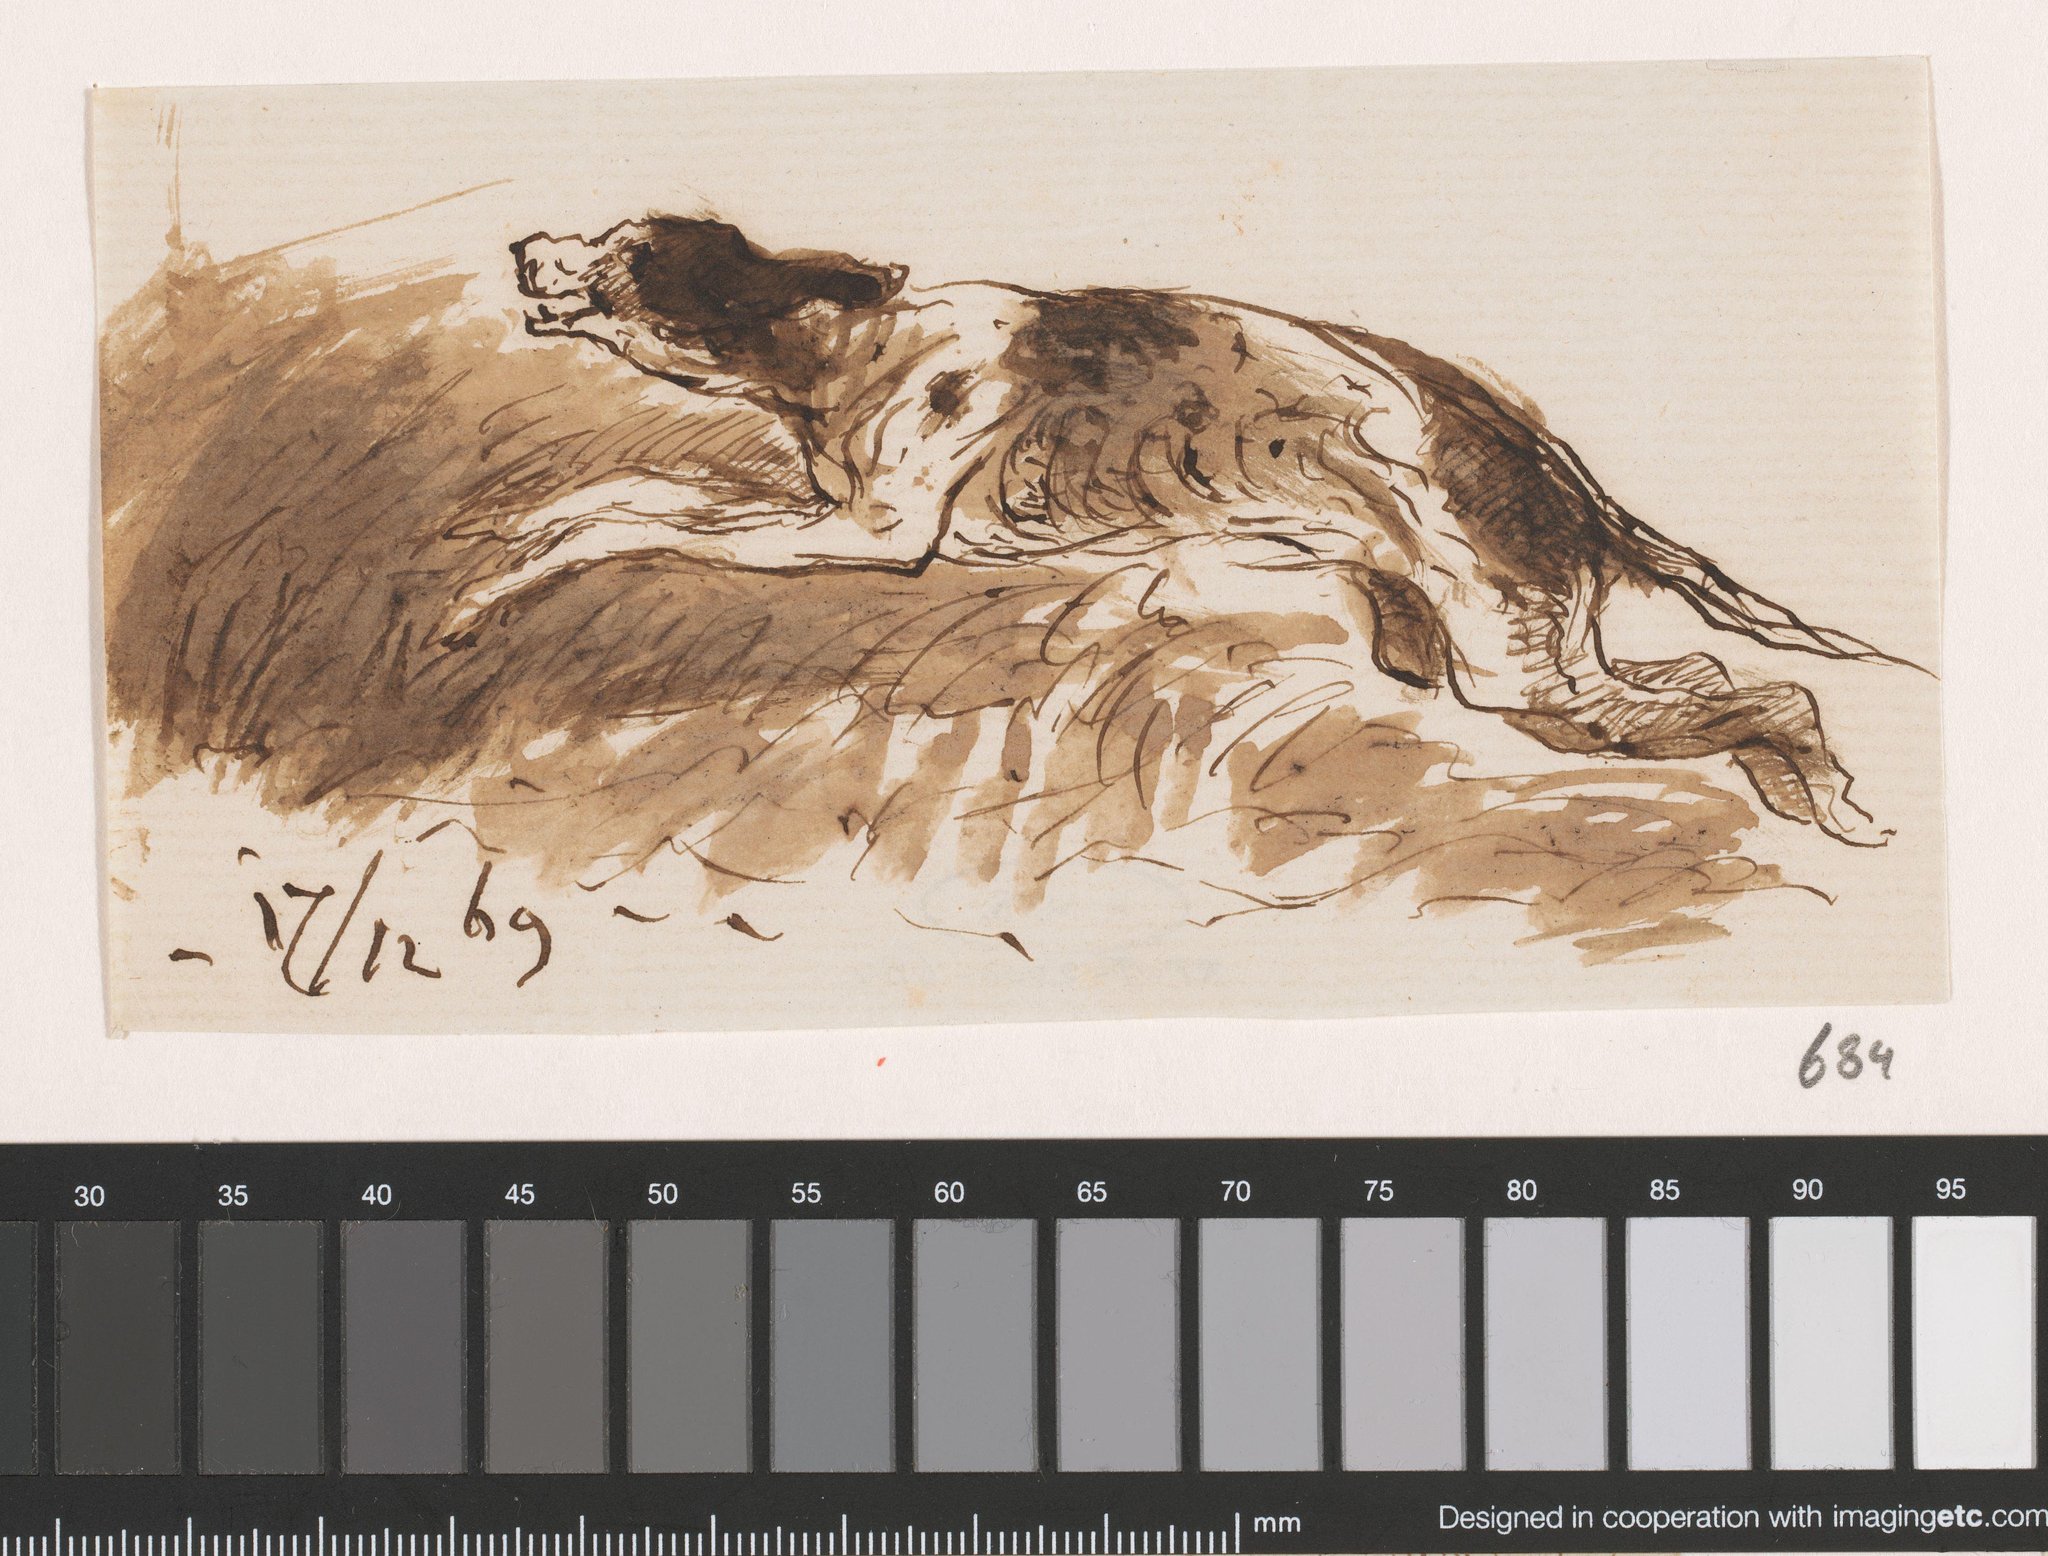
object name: drawing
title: Jachthond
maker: johannes tavenraat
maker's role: draughtsman, painter, print maker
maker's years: 1809-1881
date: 1869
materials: ink, paper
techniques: brush, pen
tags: hunting dogs, dog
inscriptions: collector's mark: Lugt 2228